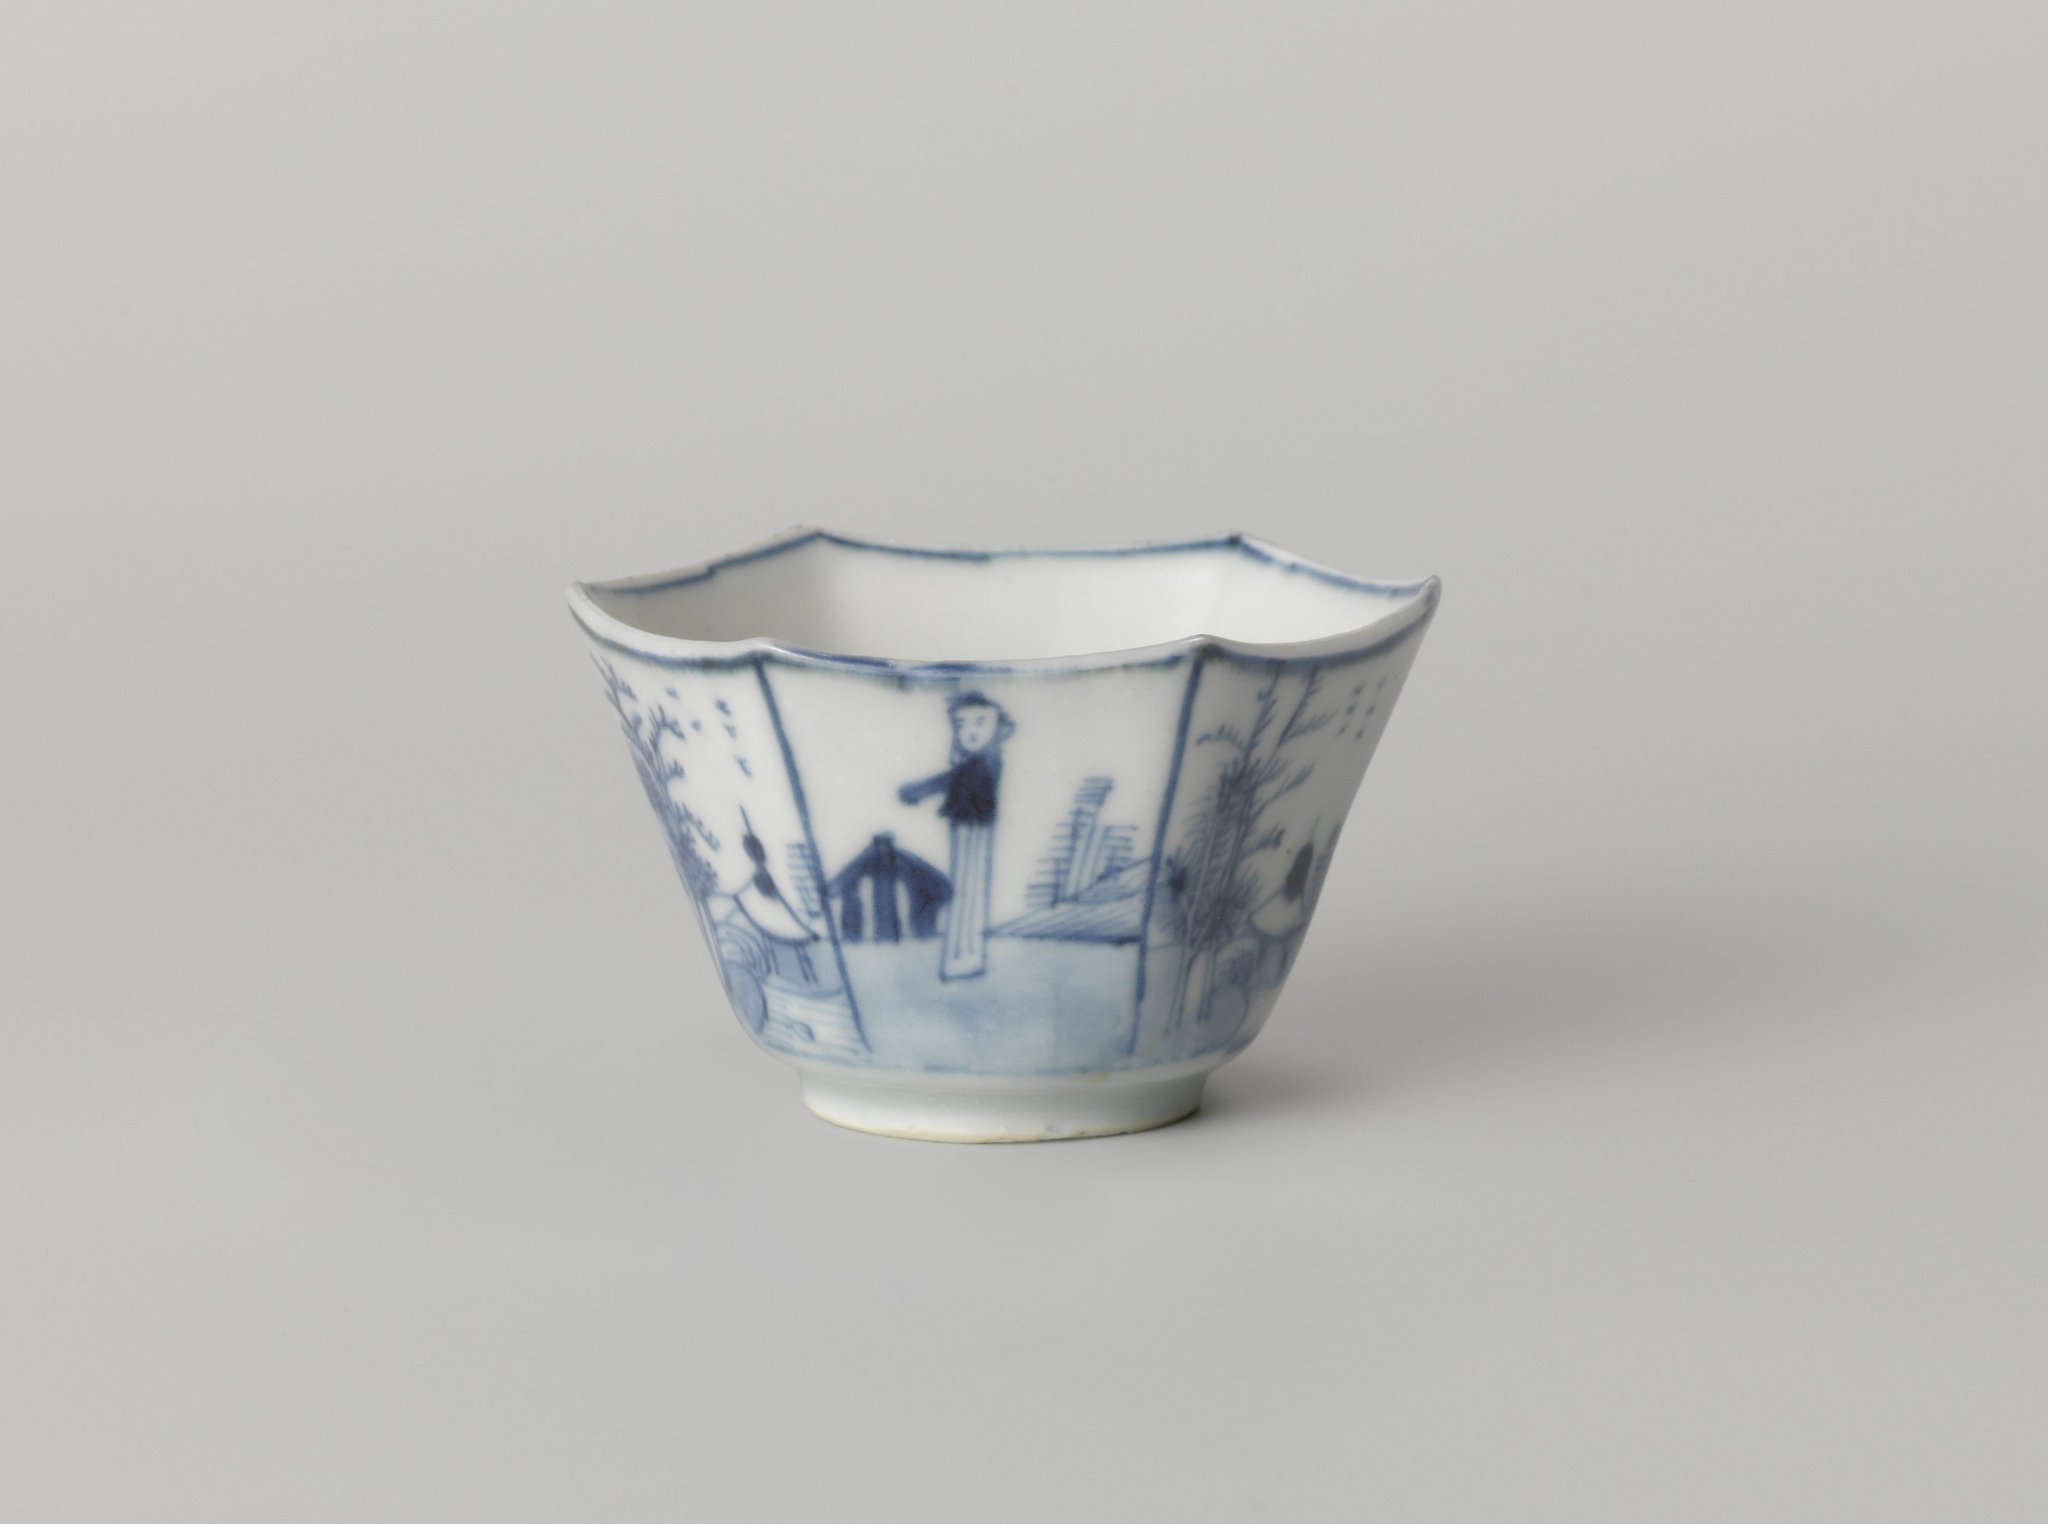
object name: cup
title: Hexagonal cup with landscapes and figures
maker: Anonymous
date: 1750-1774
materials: cobalt, glaze, paint, porcelain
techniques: firing, forming, turning, vitrification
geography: china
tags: landscapes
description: Zeshoekige kop van porselein, beschilderd in onderglazuur blauw. Op de bodem een rivierlandschap met paviljoens, bomen en een persoon; de buitenwand is verdeeld in zes vakken met afwisselend een persoon bij een hek en een rivierlandschap met een paviljoen en bomen. Blauw-wit.